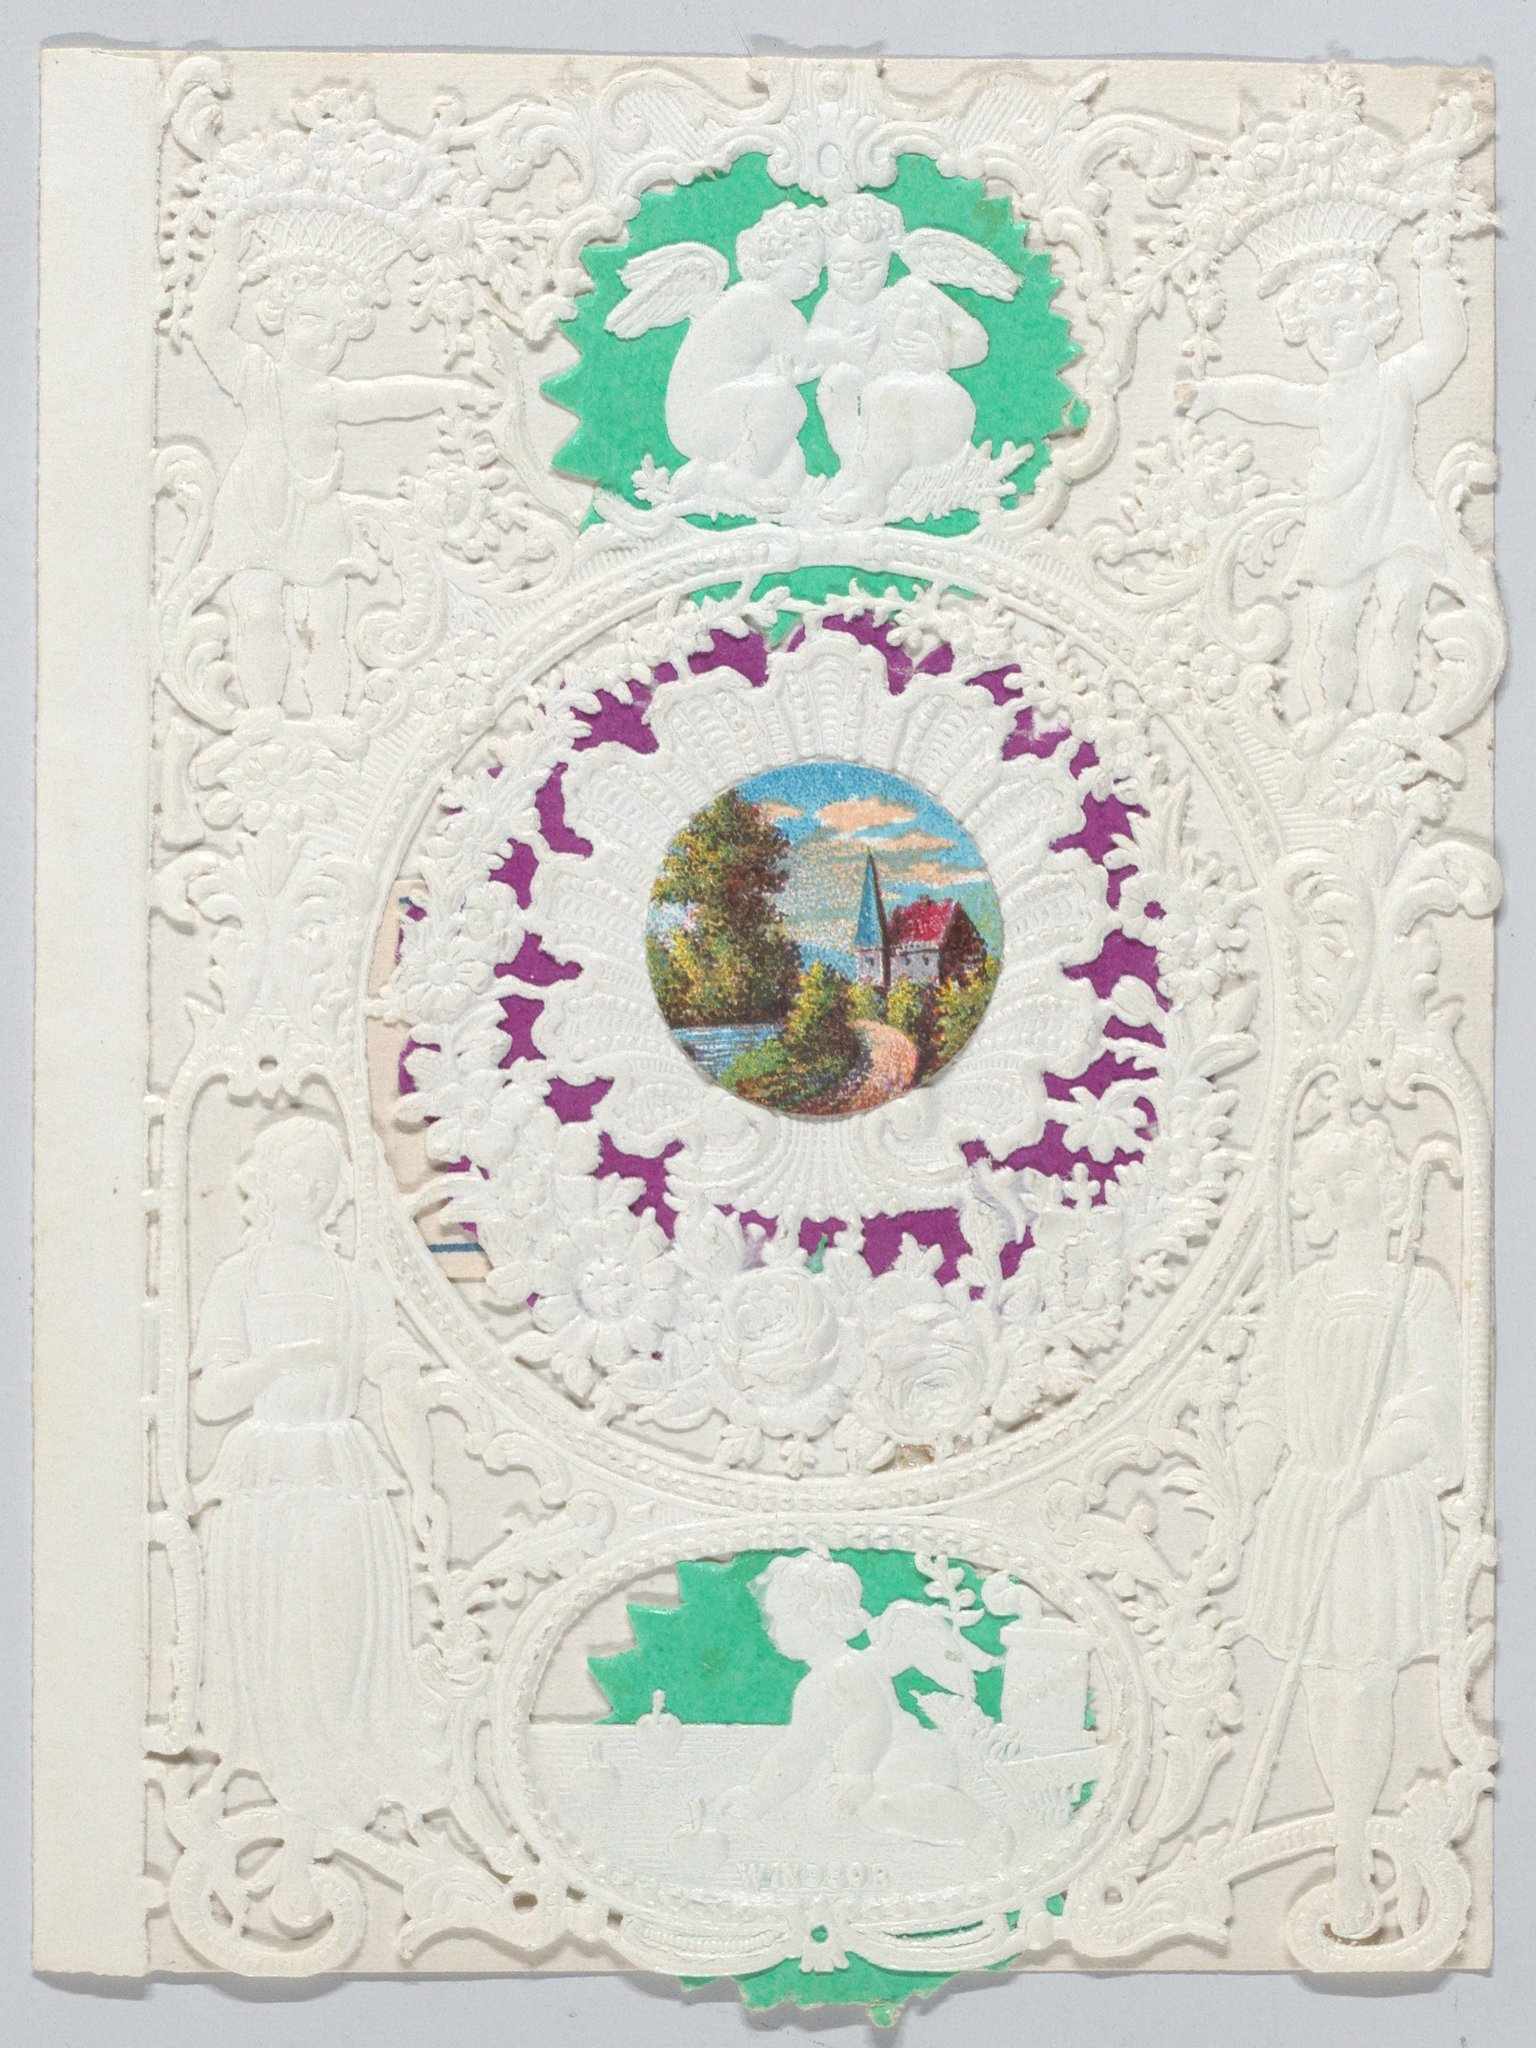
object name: valentine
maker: Anonymous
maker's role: artist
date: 1847-1870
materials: lace, paper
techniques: chromolithography, embossing, open work